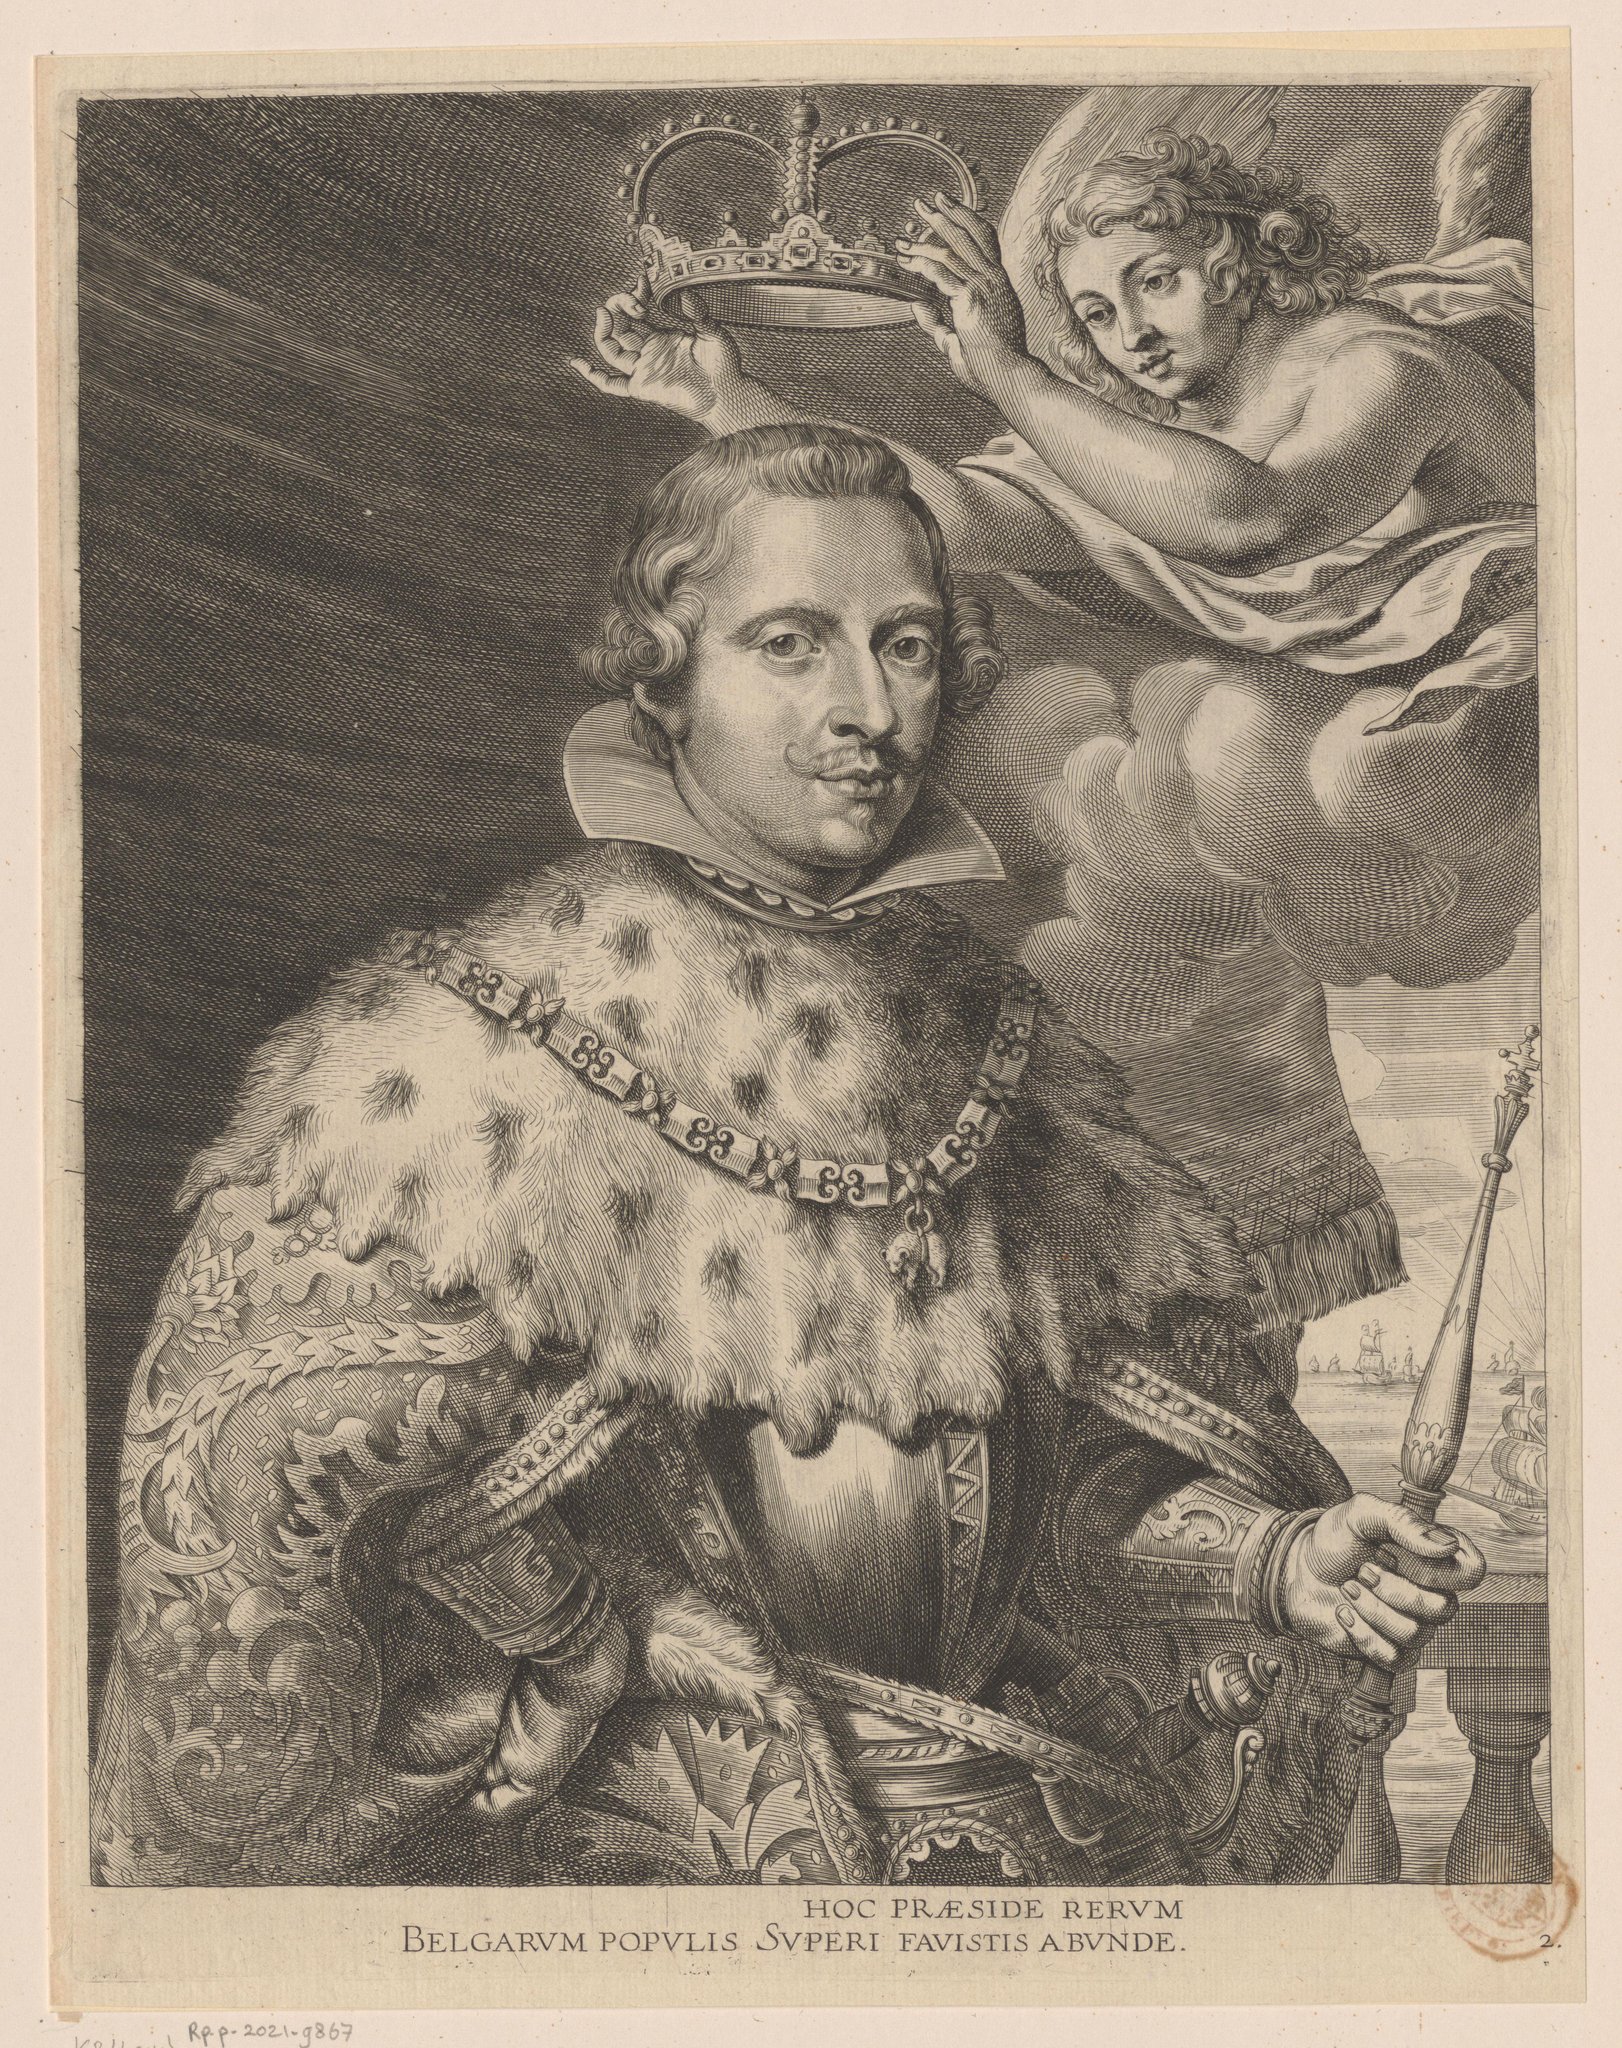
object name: print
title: Sereniss. Fernandi Cardinalis Infantis triumphalis introitus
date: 1636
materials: paper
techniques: engraving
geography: antwerp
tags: filips iv (koning van spanje), crown (symbol of sovereignty), adult man, historical persons, knighthood order of the golden fleece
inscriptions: collector's mark: Lugt 240